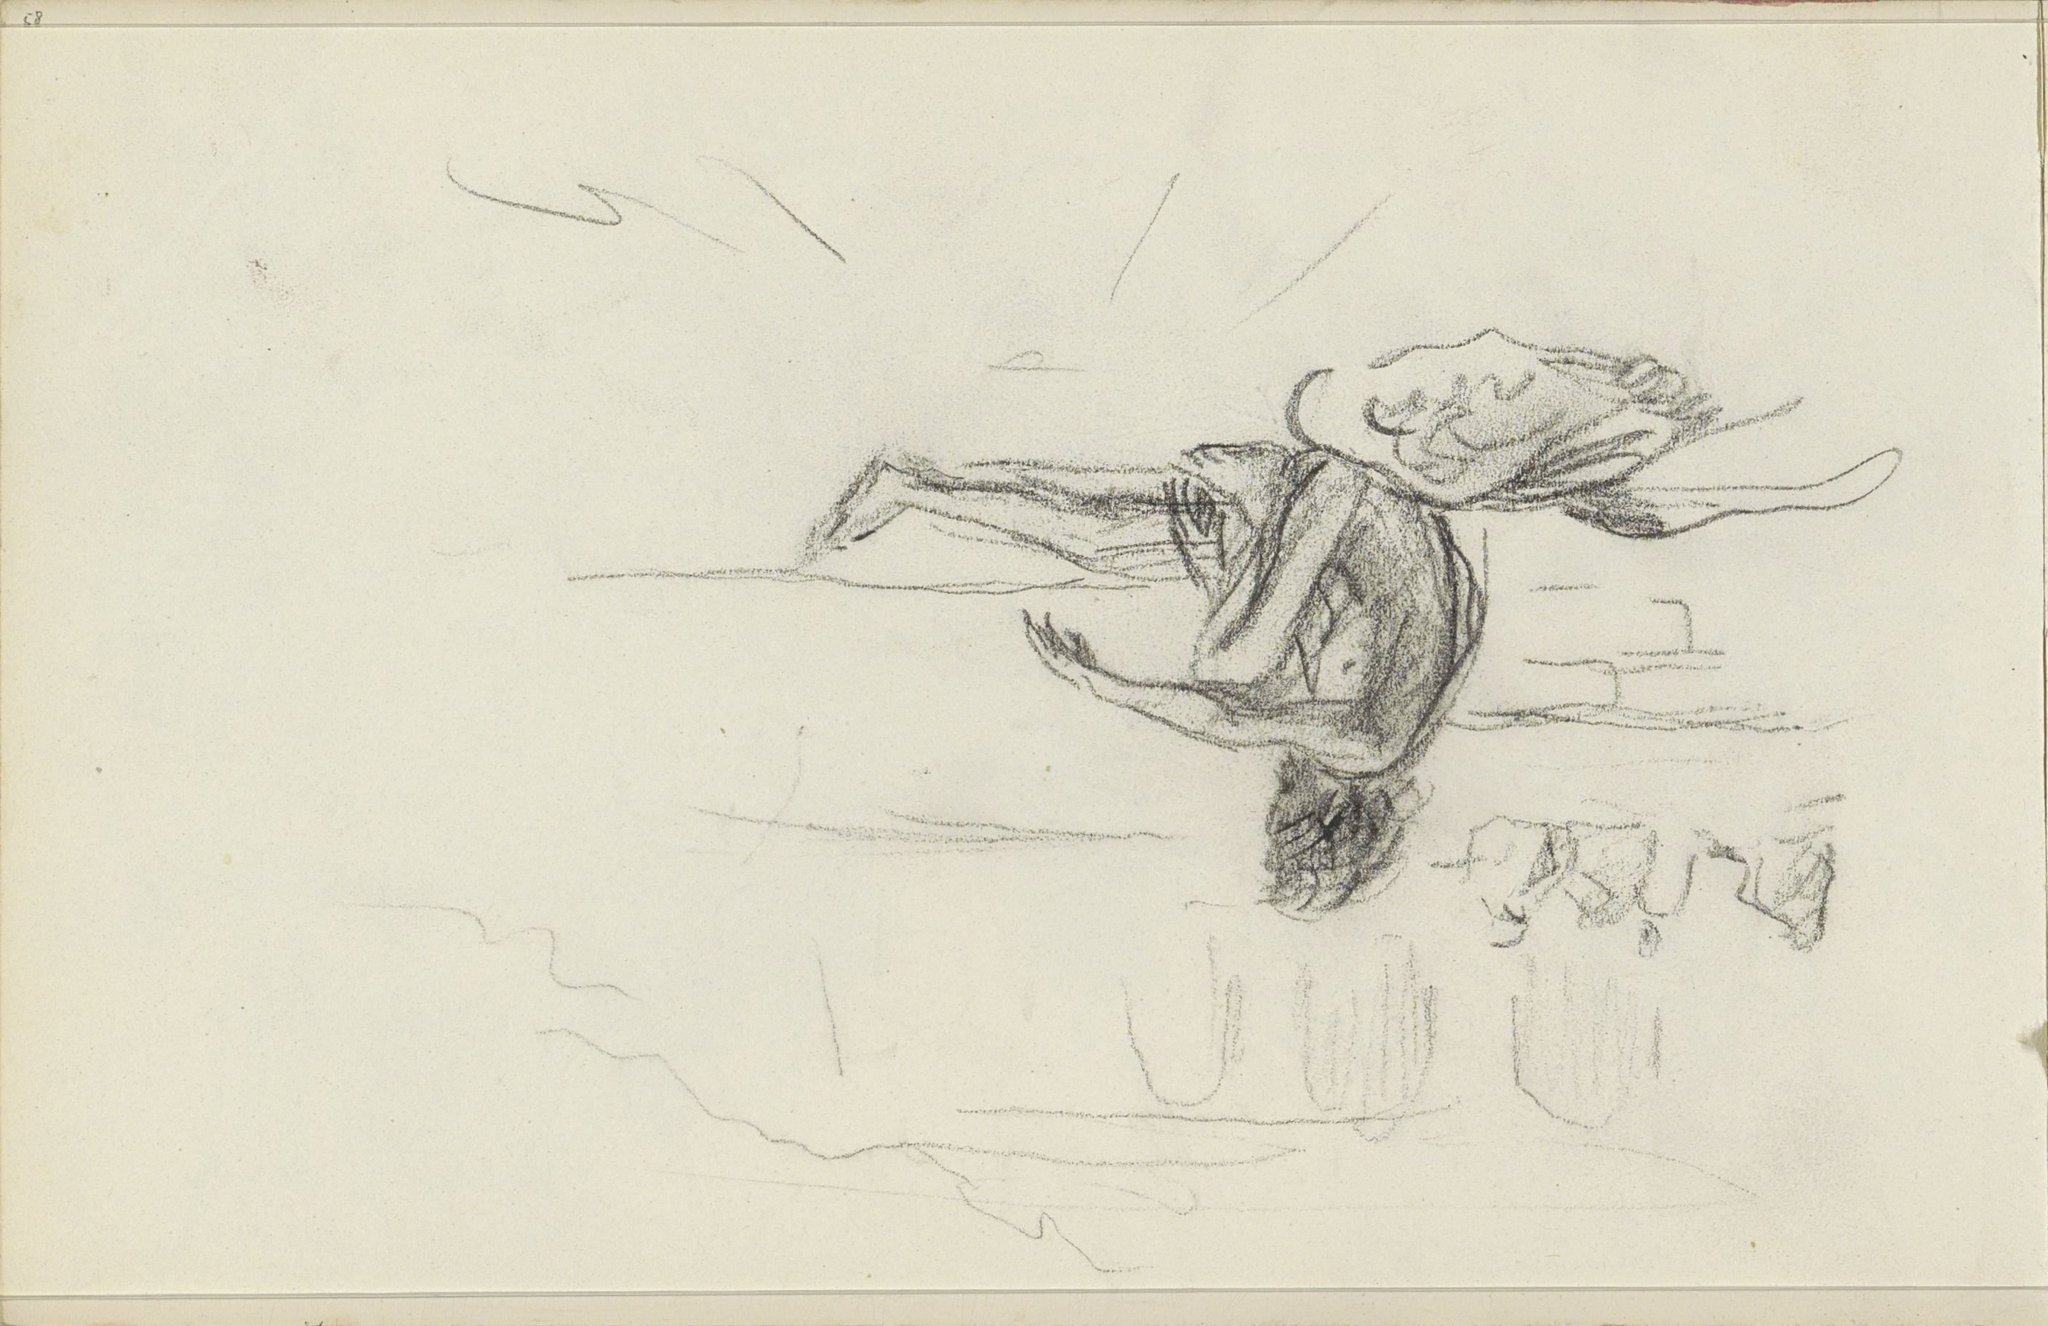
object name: sketchbook leaf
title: Zittende Indiër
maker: marius bauer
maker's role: draughtsman, print maker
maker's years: 1867-1932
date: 1924-1925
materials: chalk, paper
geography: india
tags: sitting figure, asiatic races and peoples: indians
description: Pagina 58 uit een schetsboek met 48 bladen.